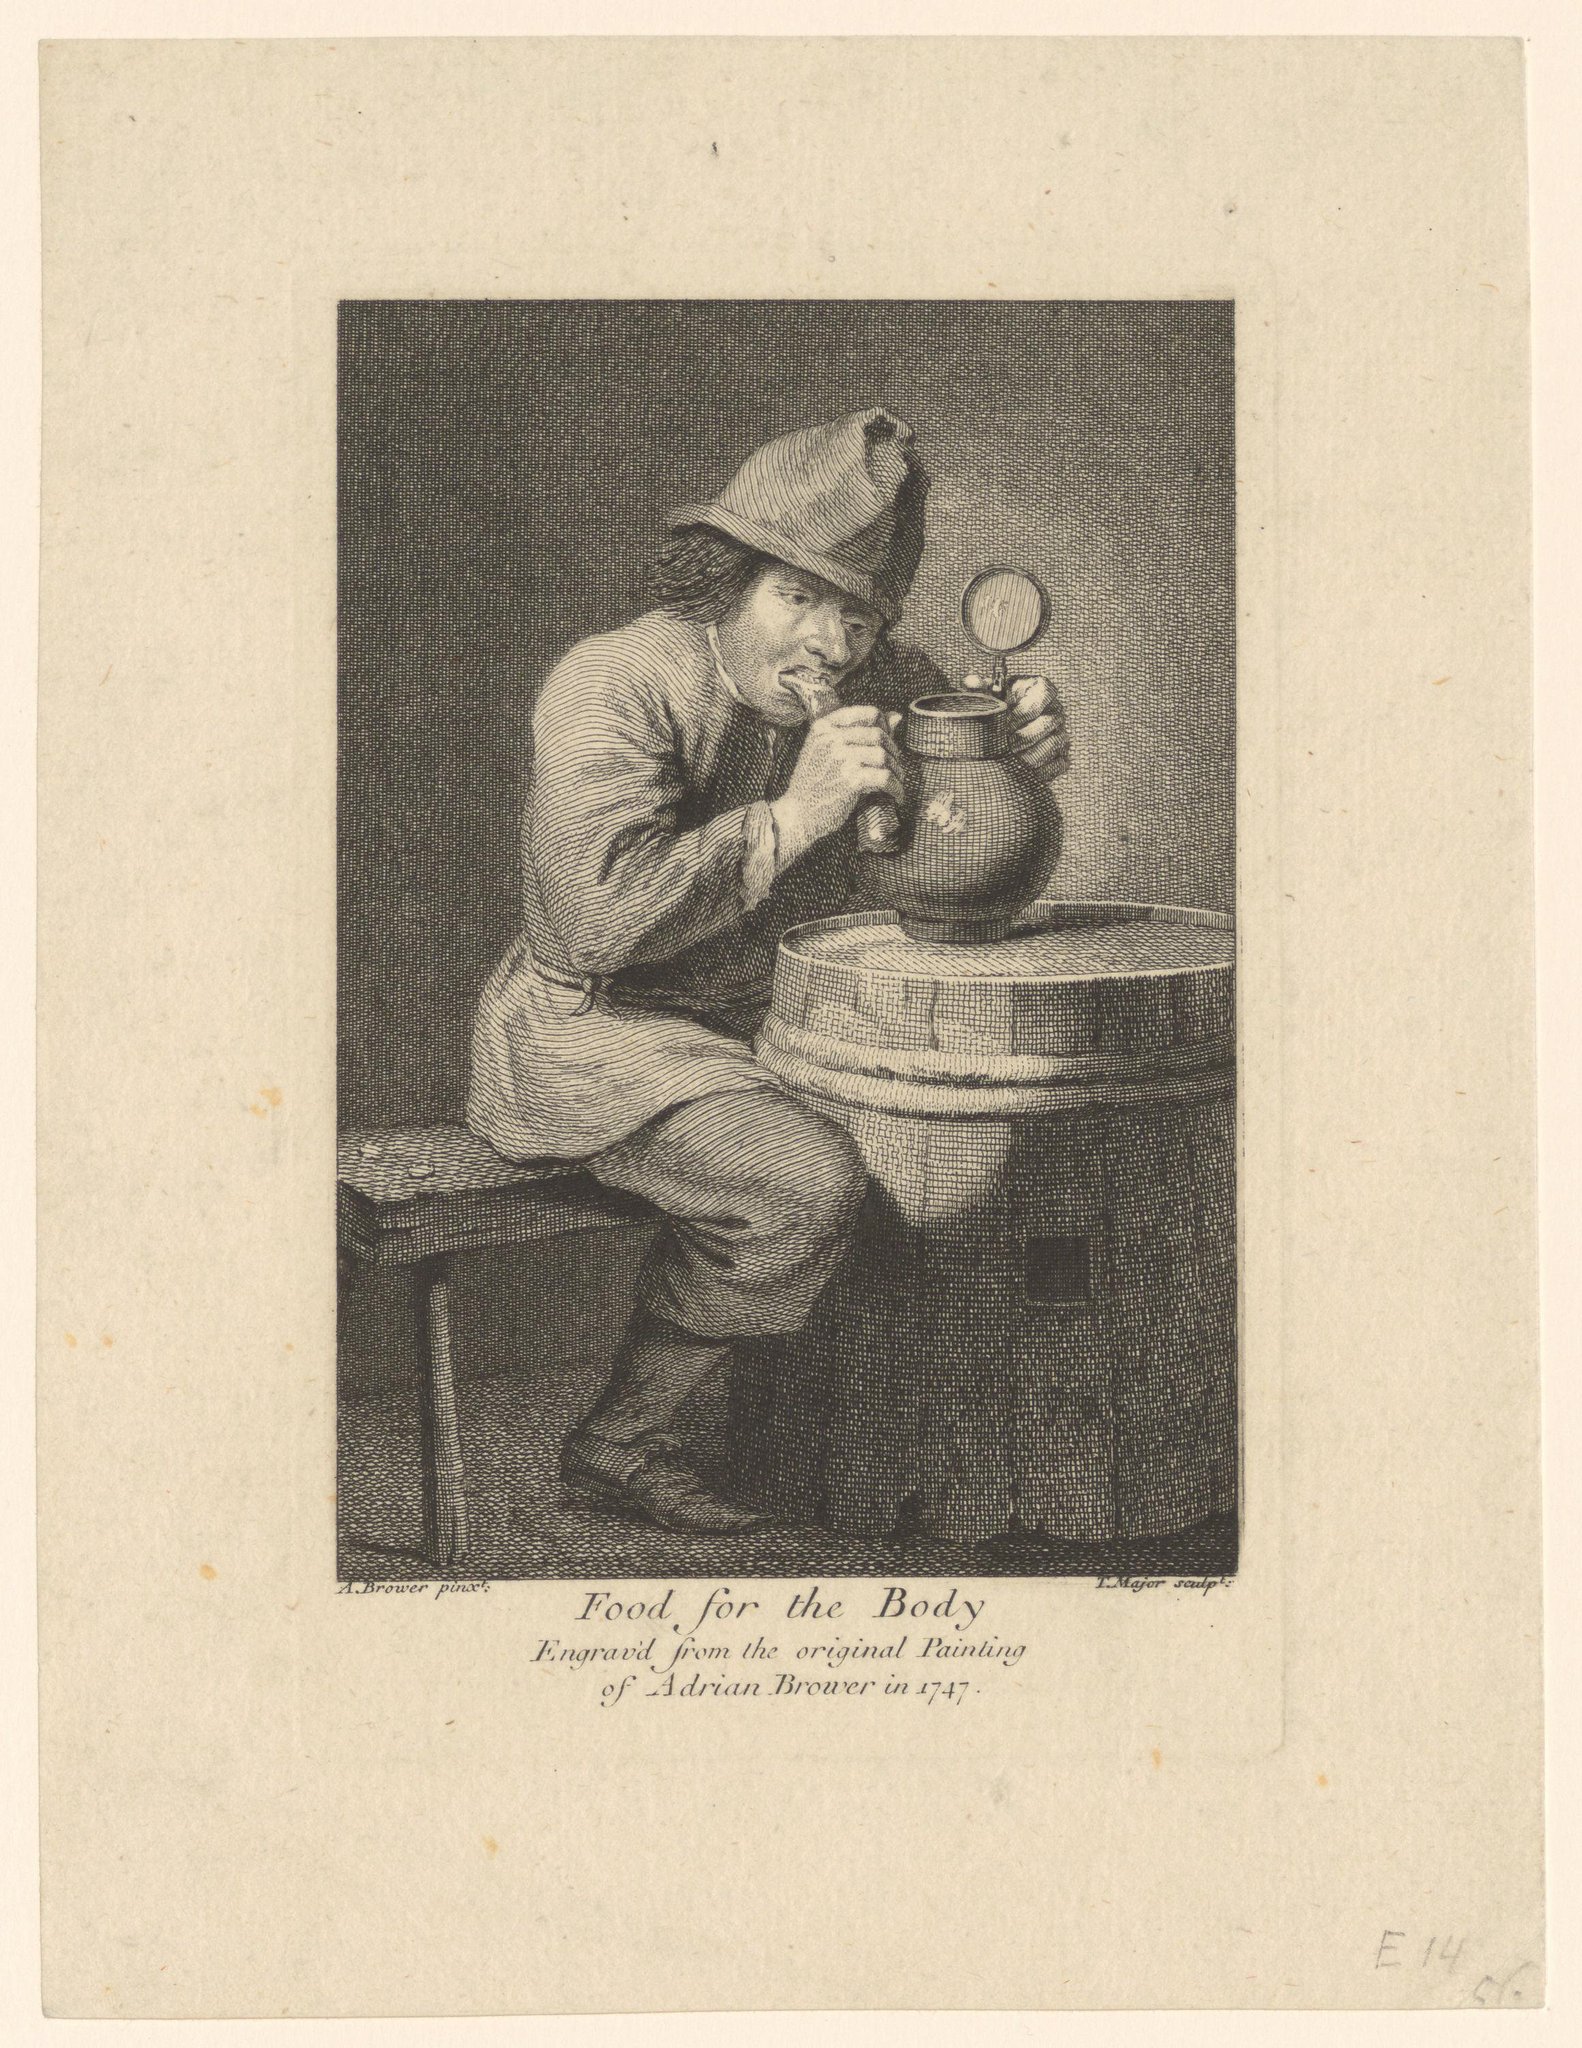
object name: print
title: Man eet en drinkt aan tafel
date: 1747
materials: paper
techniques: engraving, etching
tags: eating and drinking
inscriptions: collector's mark: Lugt 240